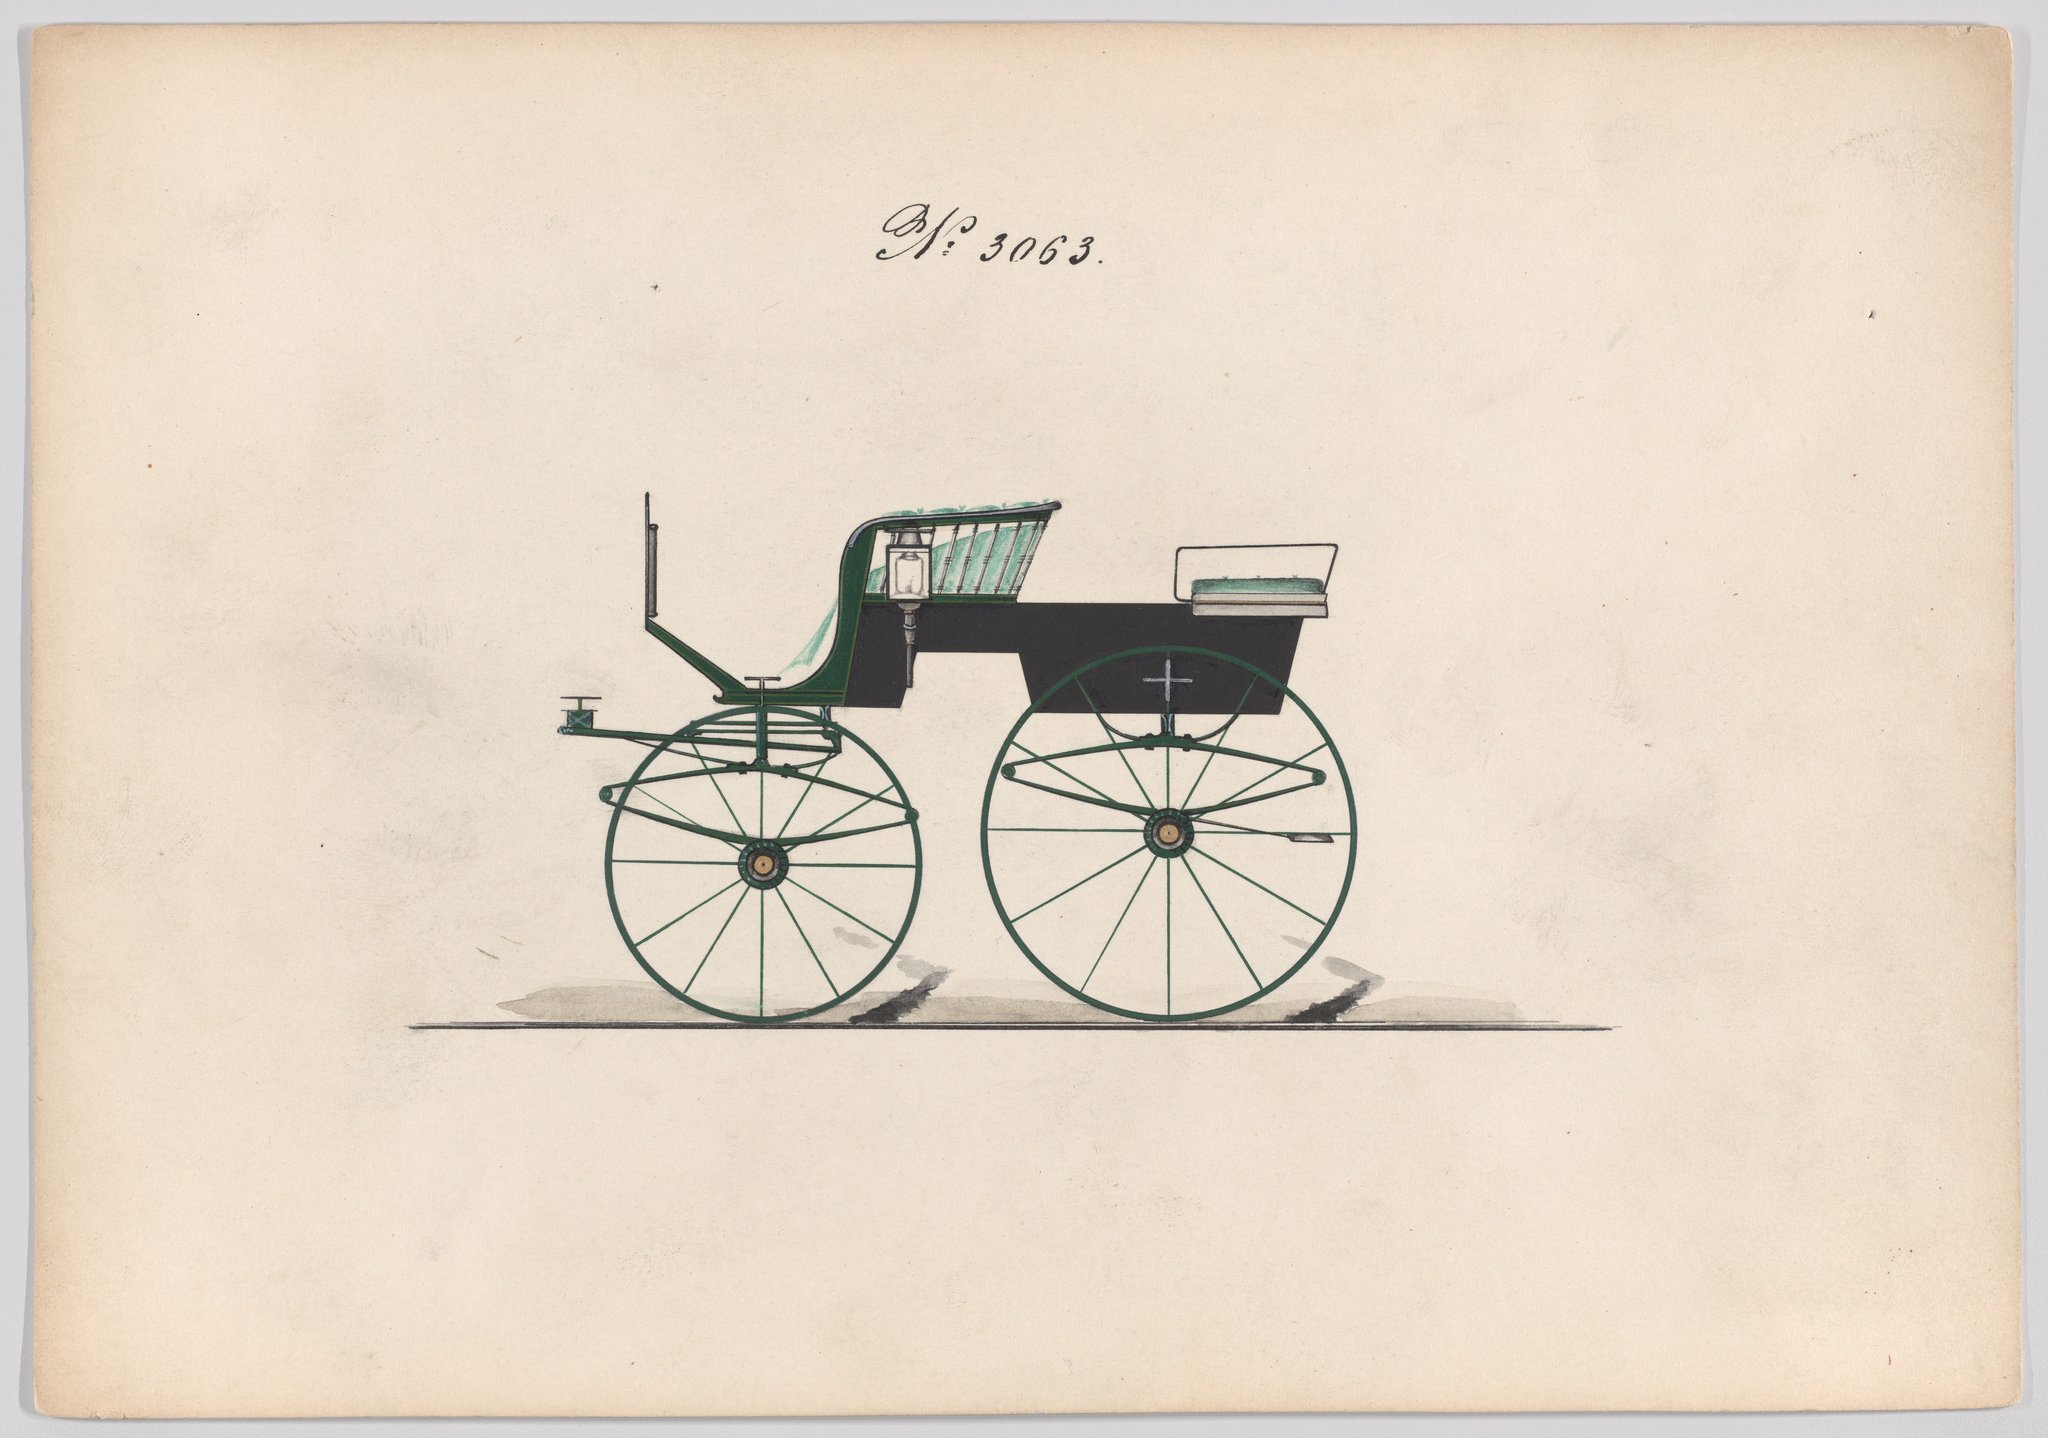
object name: drawing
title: Design for T-Cart, no. 3063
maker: brewster & co.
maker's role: manufacturer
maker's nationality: american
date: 1874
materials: gouache, gum arabic, ink, watercolor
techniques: pen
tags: carriages